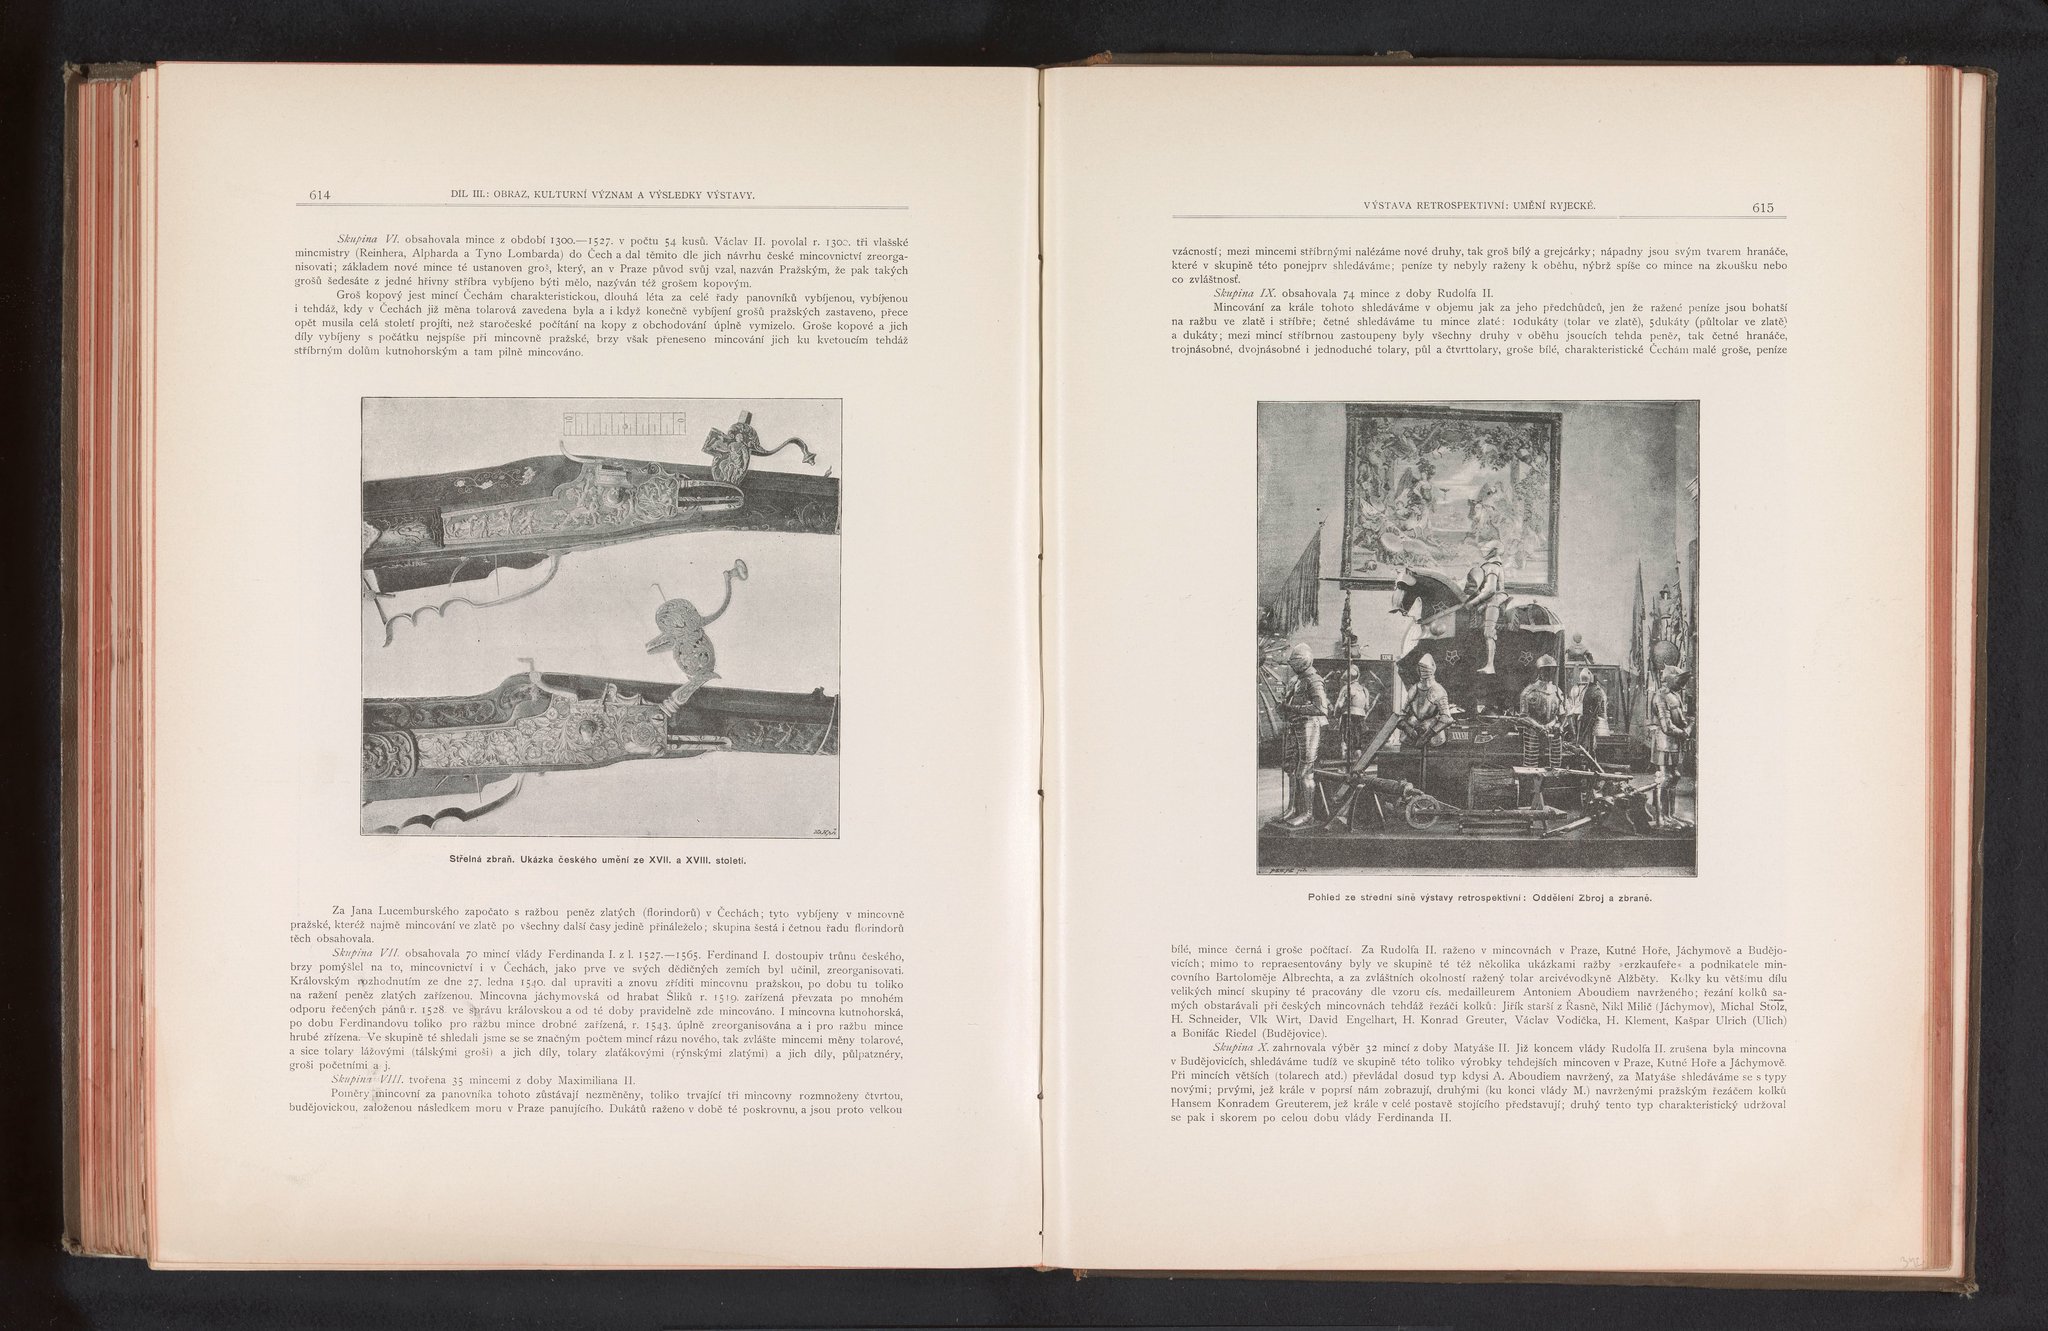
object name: photomechanical print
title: Interieur van een tentoonstelling van wapens en harnassen te Praag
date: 1891-1895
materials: paper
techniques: autotype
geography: prague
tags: armour, weapons, collection, exhibition, show